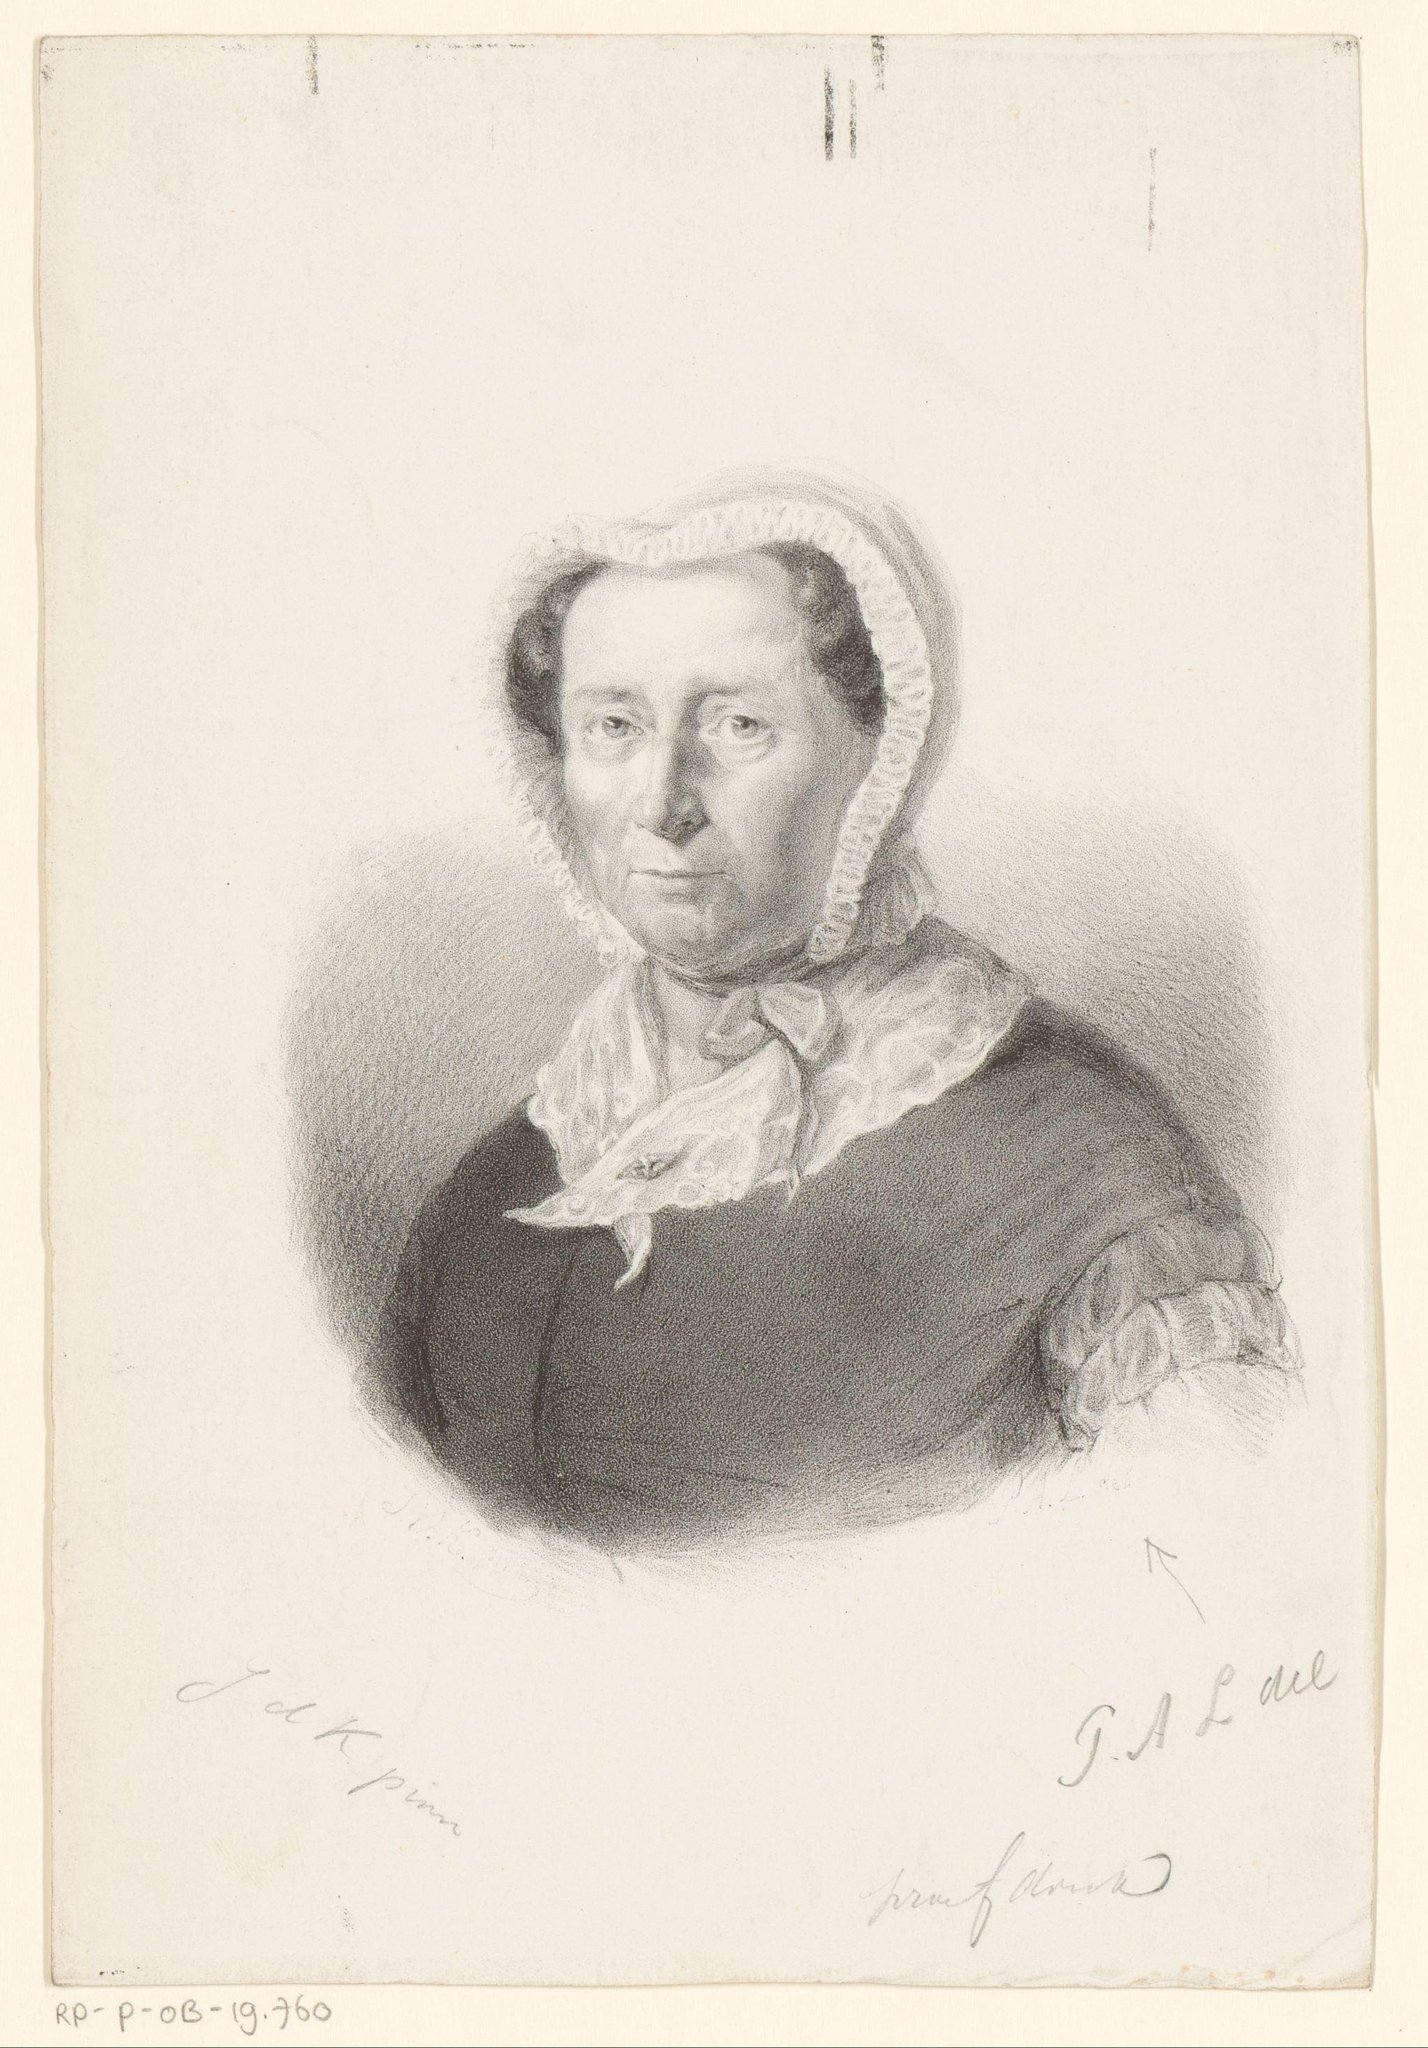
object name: print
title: Portret van een vrouw met een kap op het hoofd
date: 1836-1857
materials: paper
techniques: lithograph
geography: the hague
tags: historical persons - bb - woman (+ (full) bust portrait), head-gear: cap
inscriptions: monogram: ‘P.A.L.’, monogram: ‘J.D.K.’, collector's mark: Lugt 2228